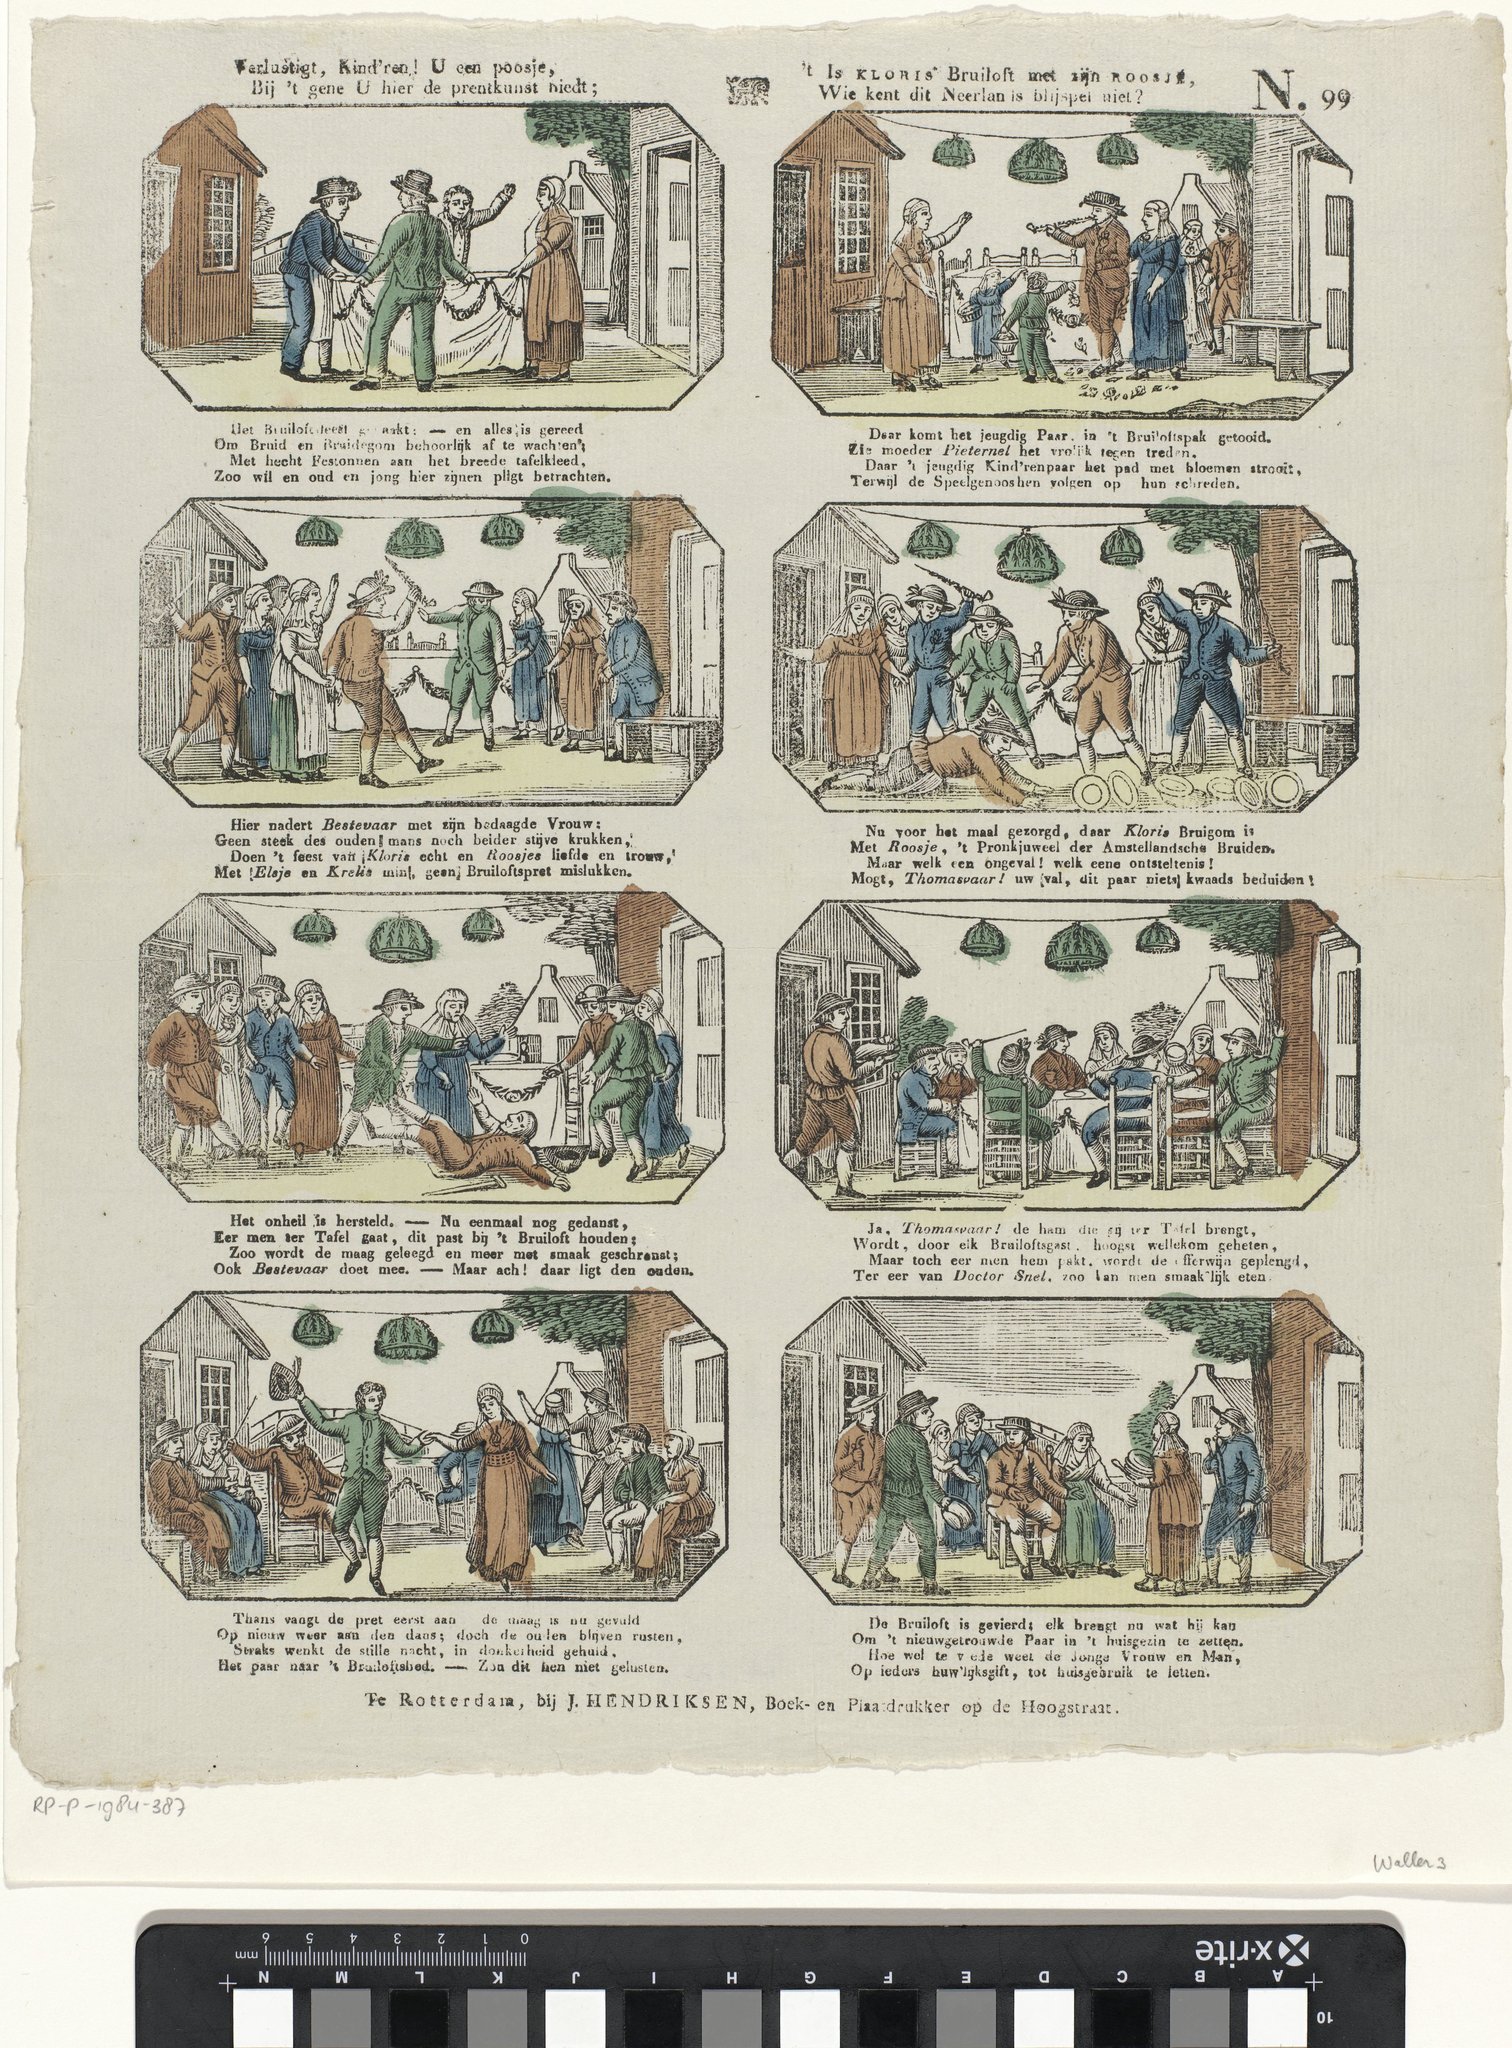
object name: popular print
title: Verlustigt, Kind'ren! U een poosje, / Bij 't gene U hier de prentkunst biedt; / 't is Kloris' bruiloft met zijn Roosje, / Wie kent dit Neerlan is blijspel niet?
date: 1781-1828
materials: paper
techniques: colour, letterpress printing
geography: netherlands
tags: wedding feast, wedding meal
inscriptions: collector's mark: Lugt 2760, collector's mark: Lugt 2228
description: Blad met 8 voorstellingen over de bruiloft van Kloris en Roosje. Onder elke afbeelding een vierregelig vers. Genummerd rechtsboven: N. 99.